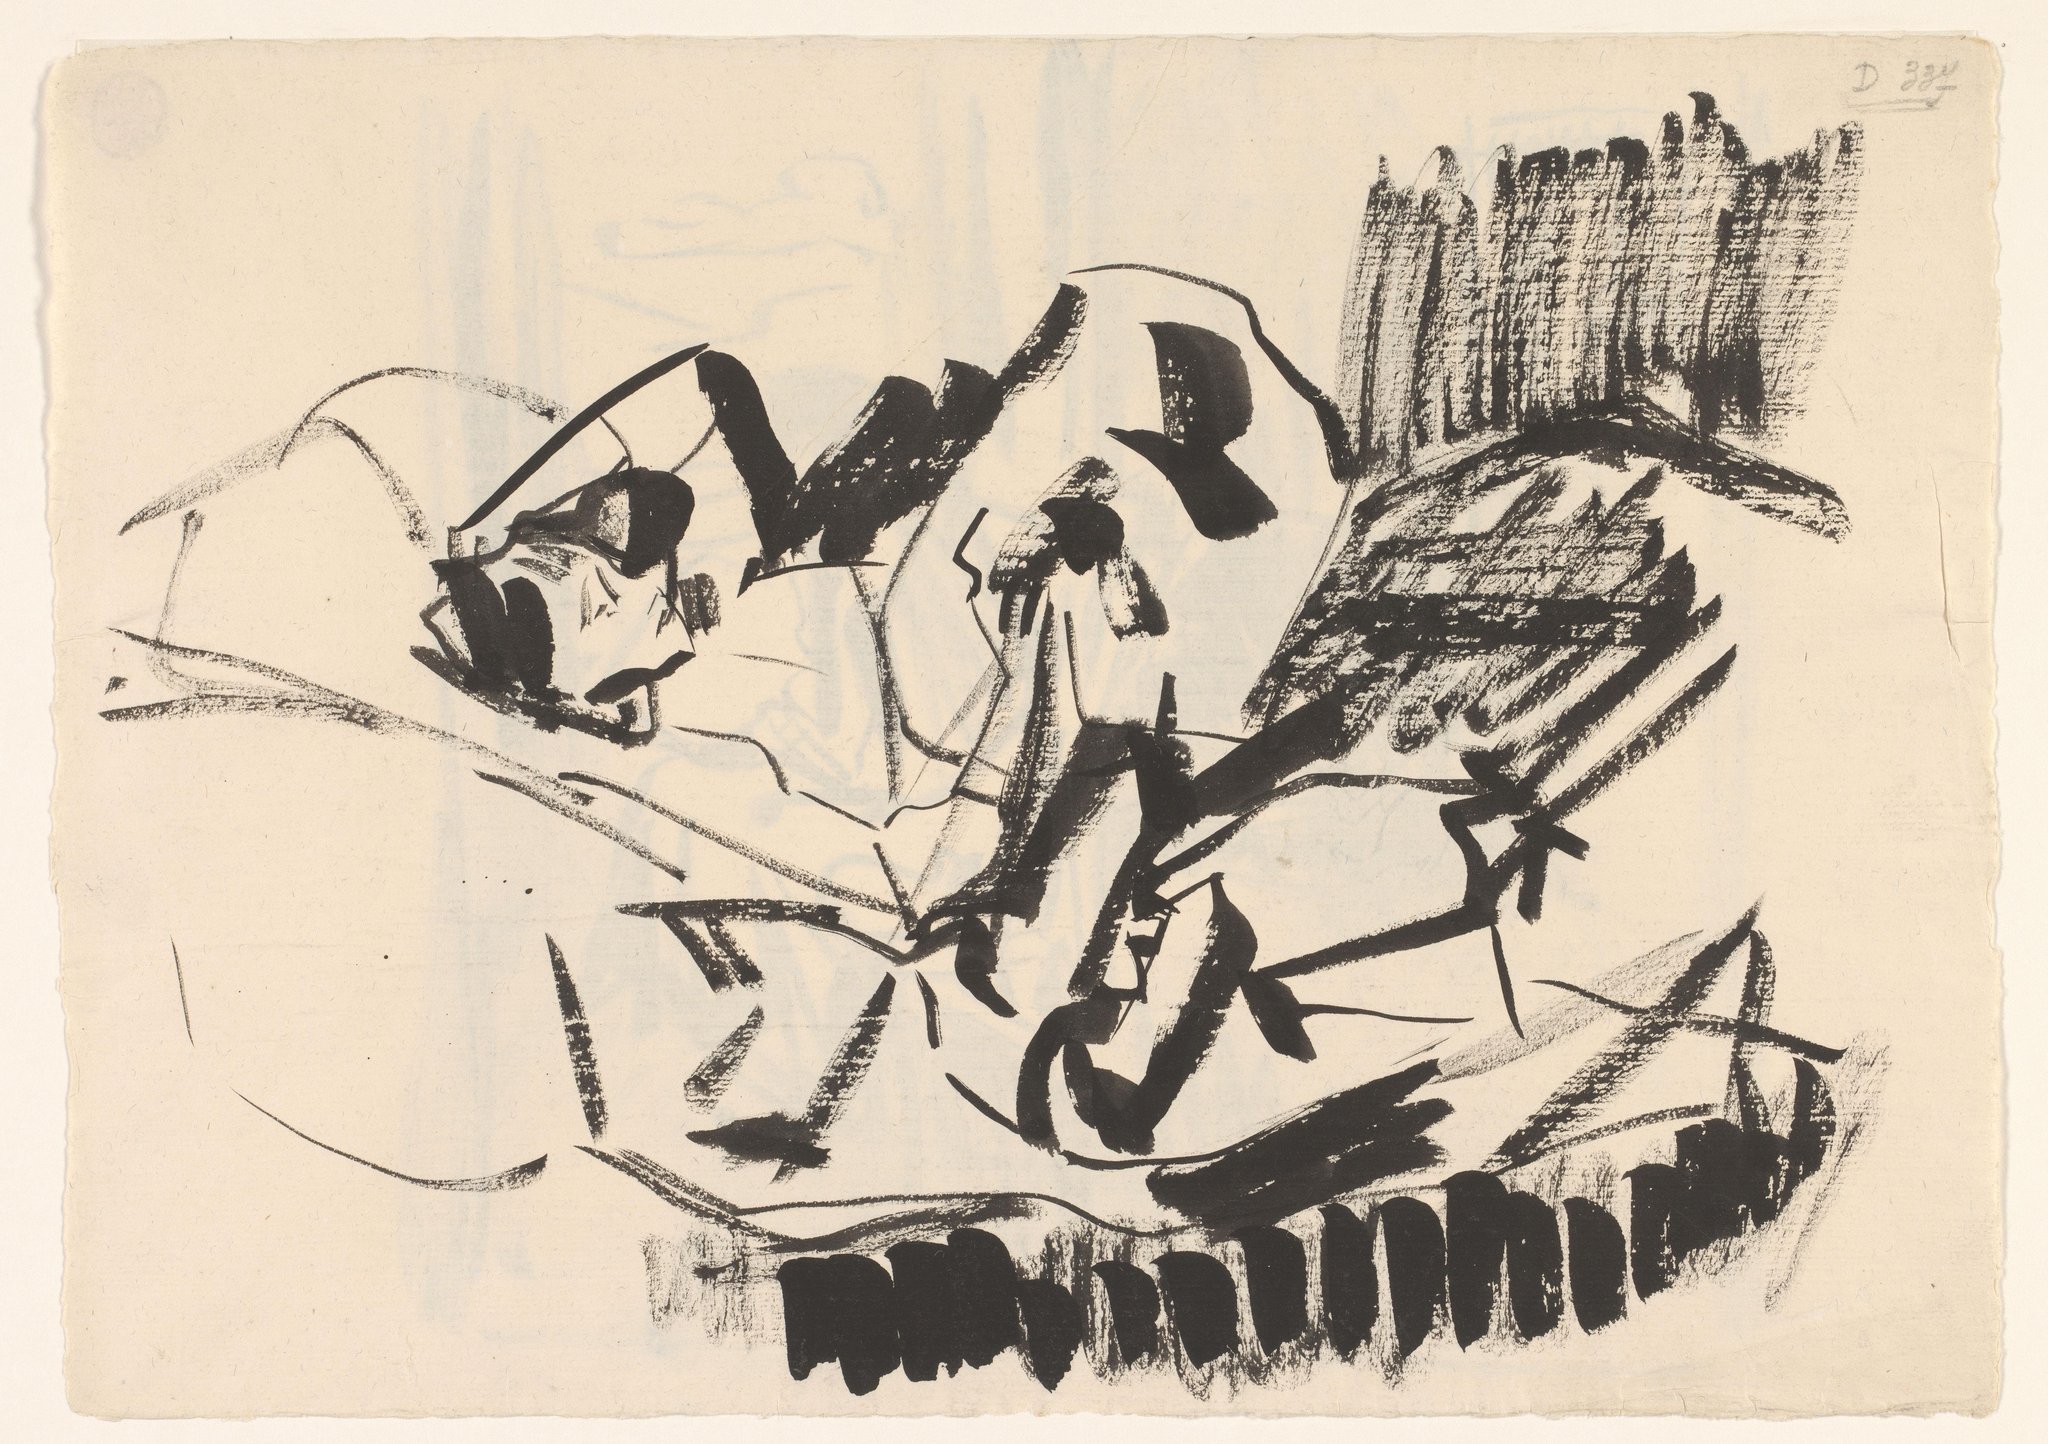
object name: drawing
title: In bed liggende vrouw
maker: rik wouters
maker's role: draughtsman, print maker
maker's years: 1882-1916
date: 1892-1916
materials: paper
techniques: brush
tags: lying figure - aa - female human figure, dog